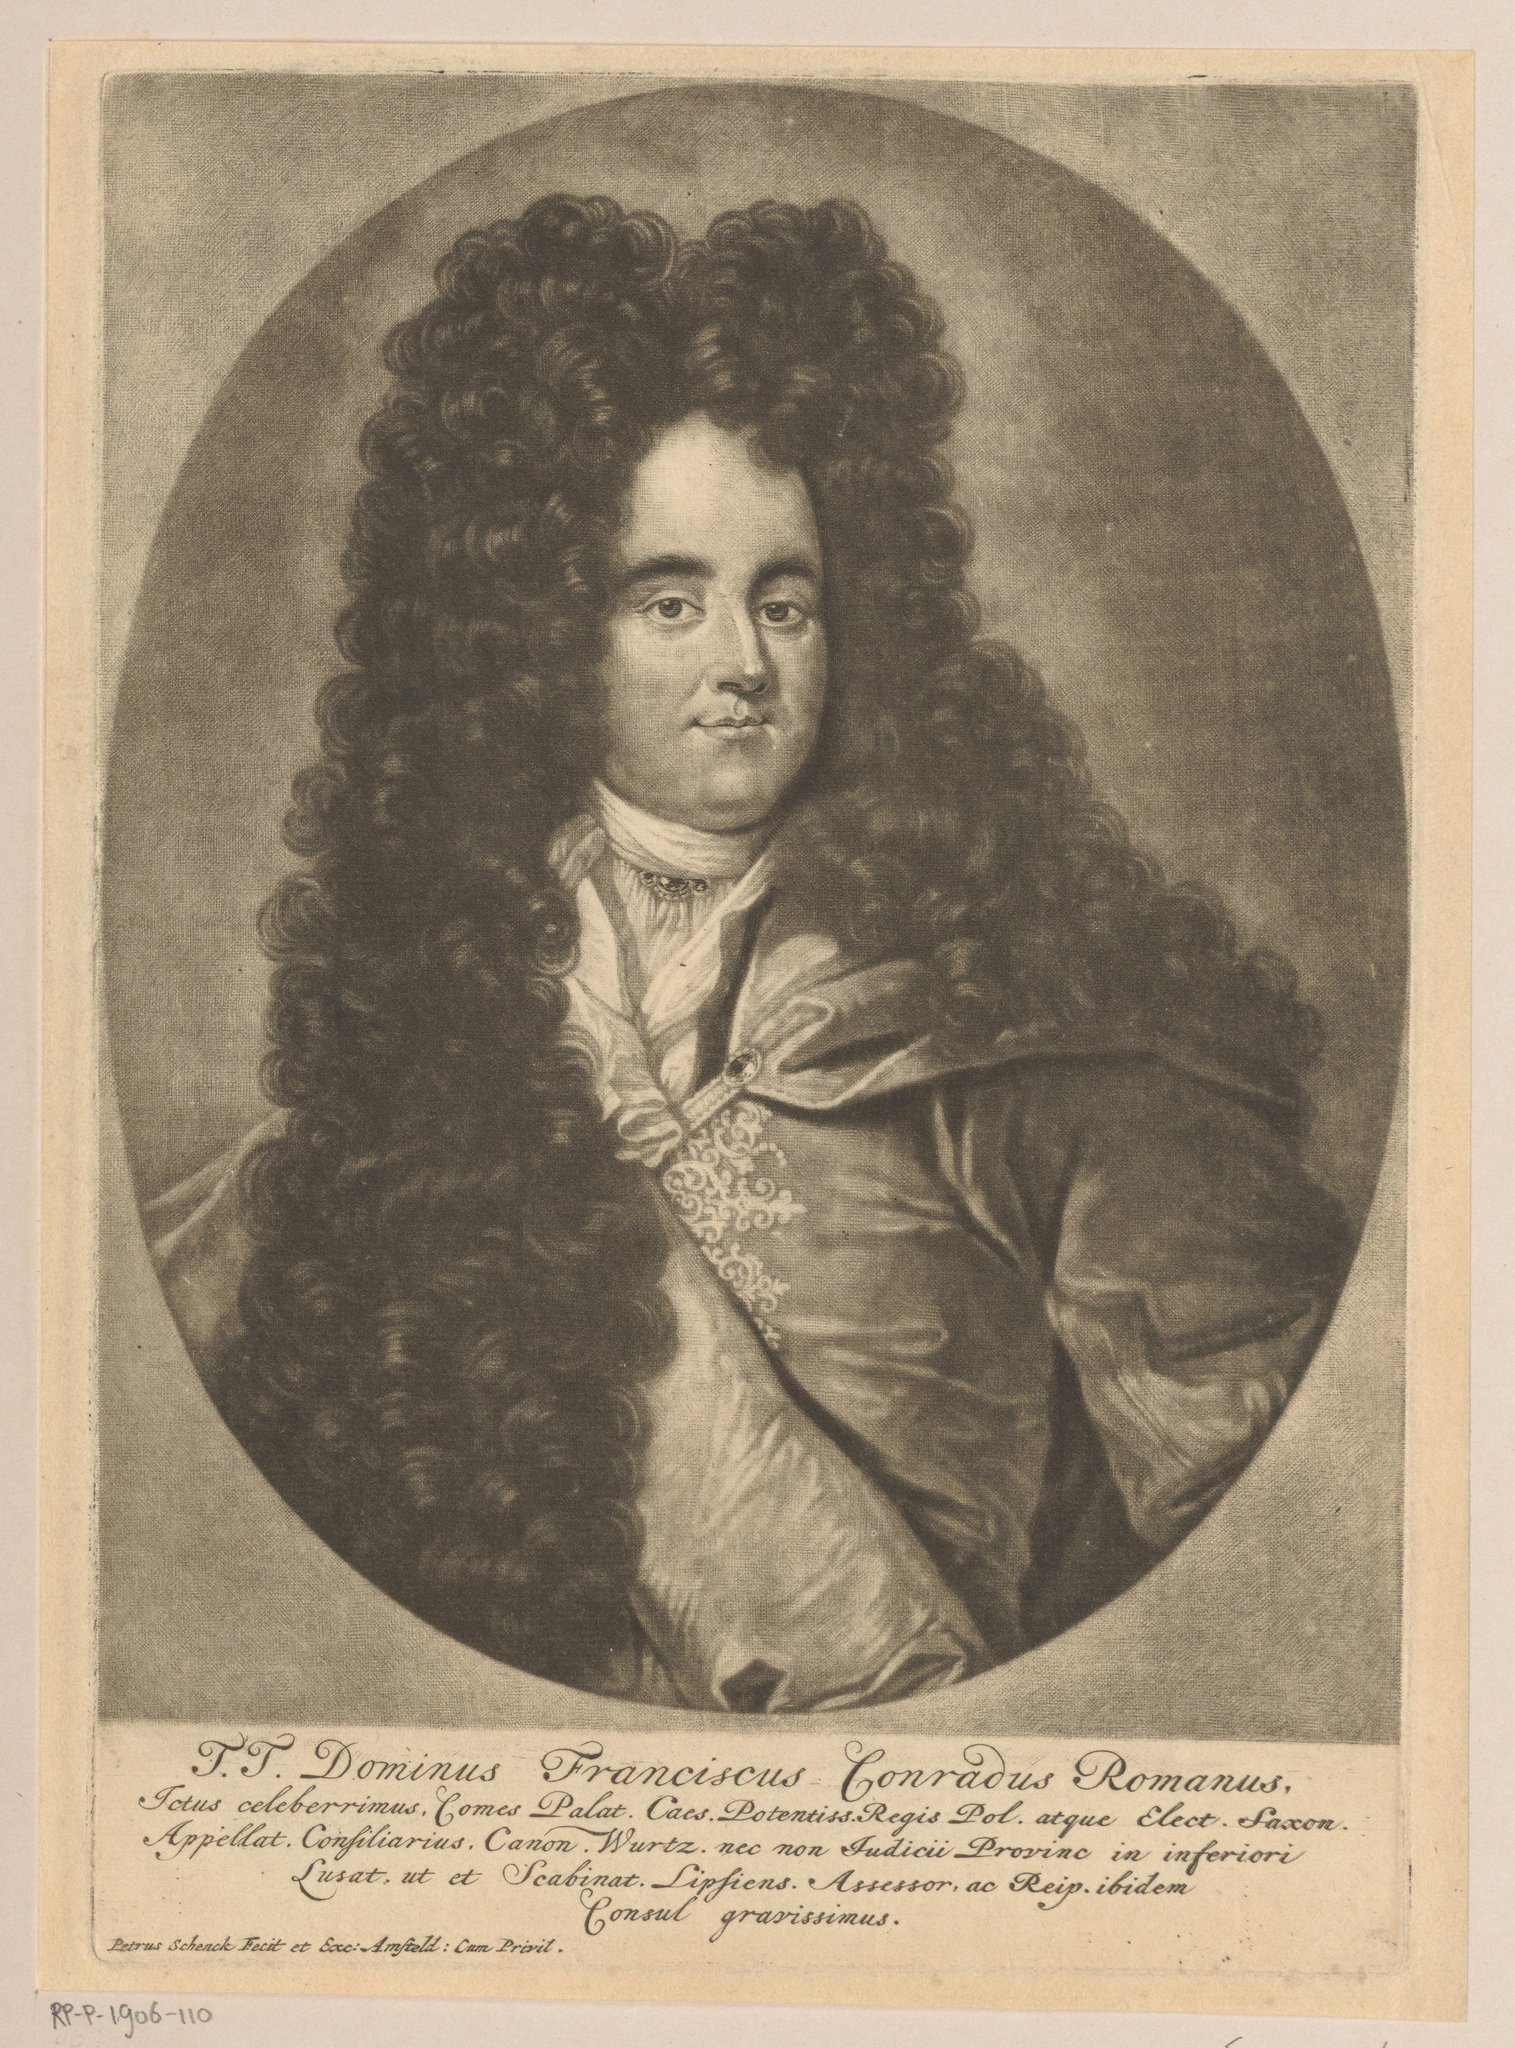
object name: print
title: Portret van Franz Konrad Romanus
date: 1675-1711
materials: paper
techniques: engraving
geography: amsterdam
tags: historical persons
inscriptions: collector's mark: Lugt 2228